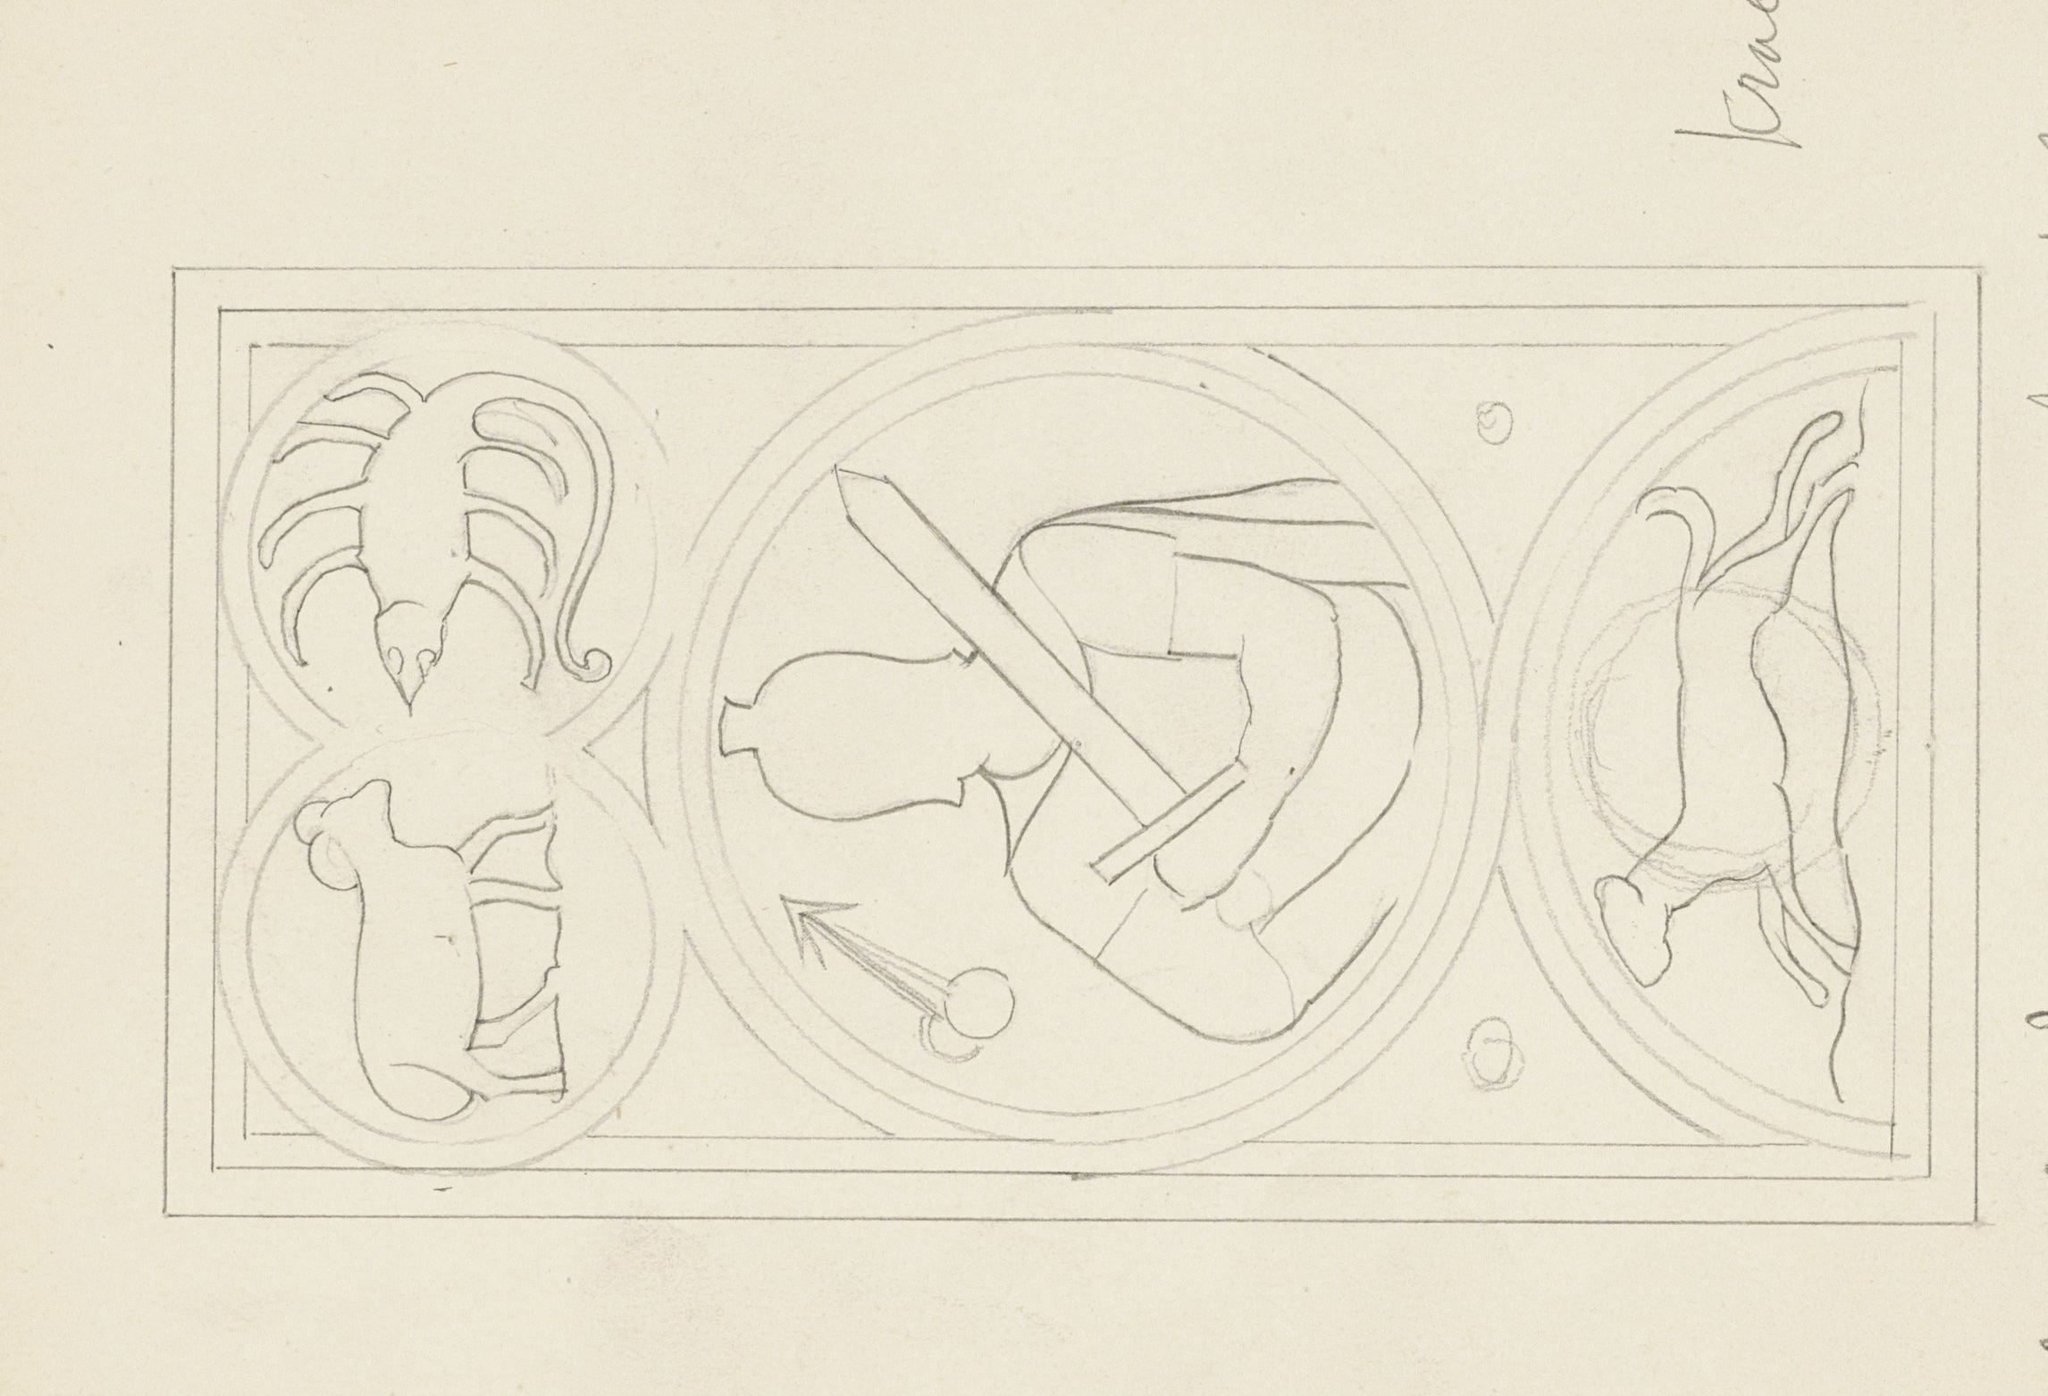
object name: sketchbook leaf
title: Mars in een medaillon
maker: antoon derkinderen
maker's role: draughtsman, painter, print maker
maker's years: 1859-1925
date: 1900-1903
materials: paper, pencil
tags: (story of) mars (ares), scorpio (zodiacal sign of october), aries (zodical sign of march), attributes of mars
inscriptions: annotation: ‘kracht/ leeuw of zwaard/ [...]/ strijd- dood slag - moed/ [...]’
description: Mars draagt een zwaard en helm. Boven het medaillon twee kleinere medaillons met voorstellingen van de sterrenbeelden ram en schorpioen. Ontwerp voor een glas-in-loodraam voor de Kamer van Koophandel in de Beurs van Berlage te Amsterdam. Blad 5 recto uit een schetsboek met 45 bladen.